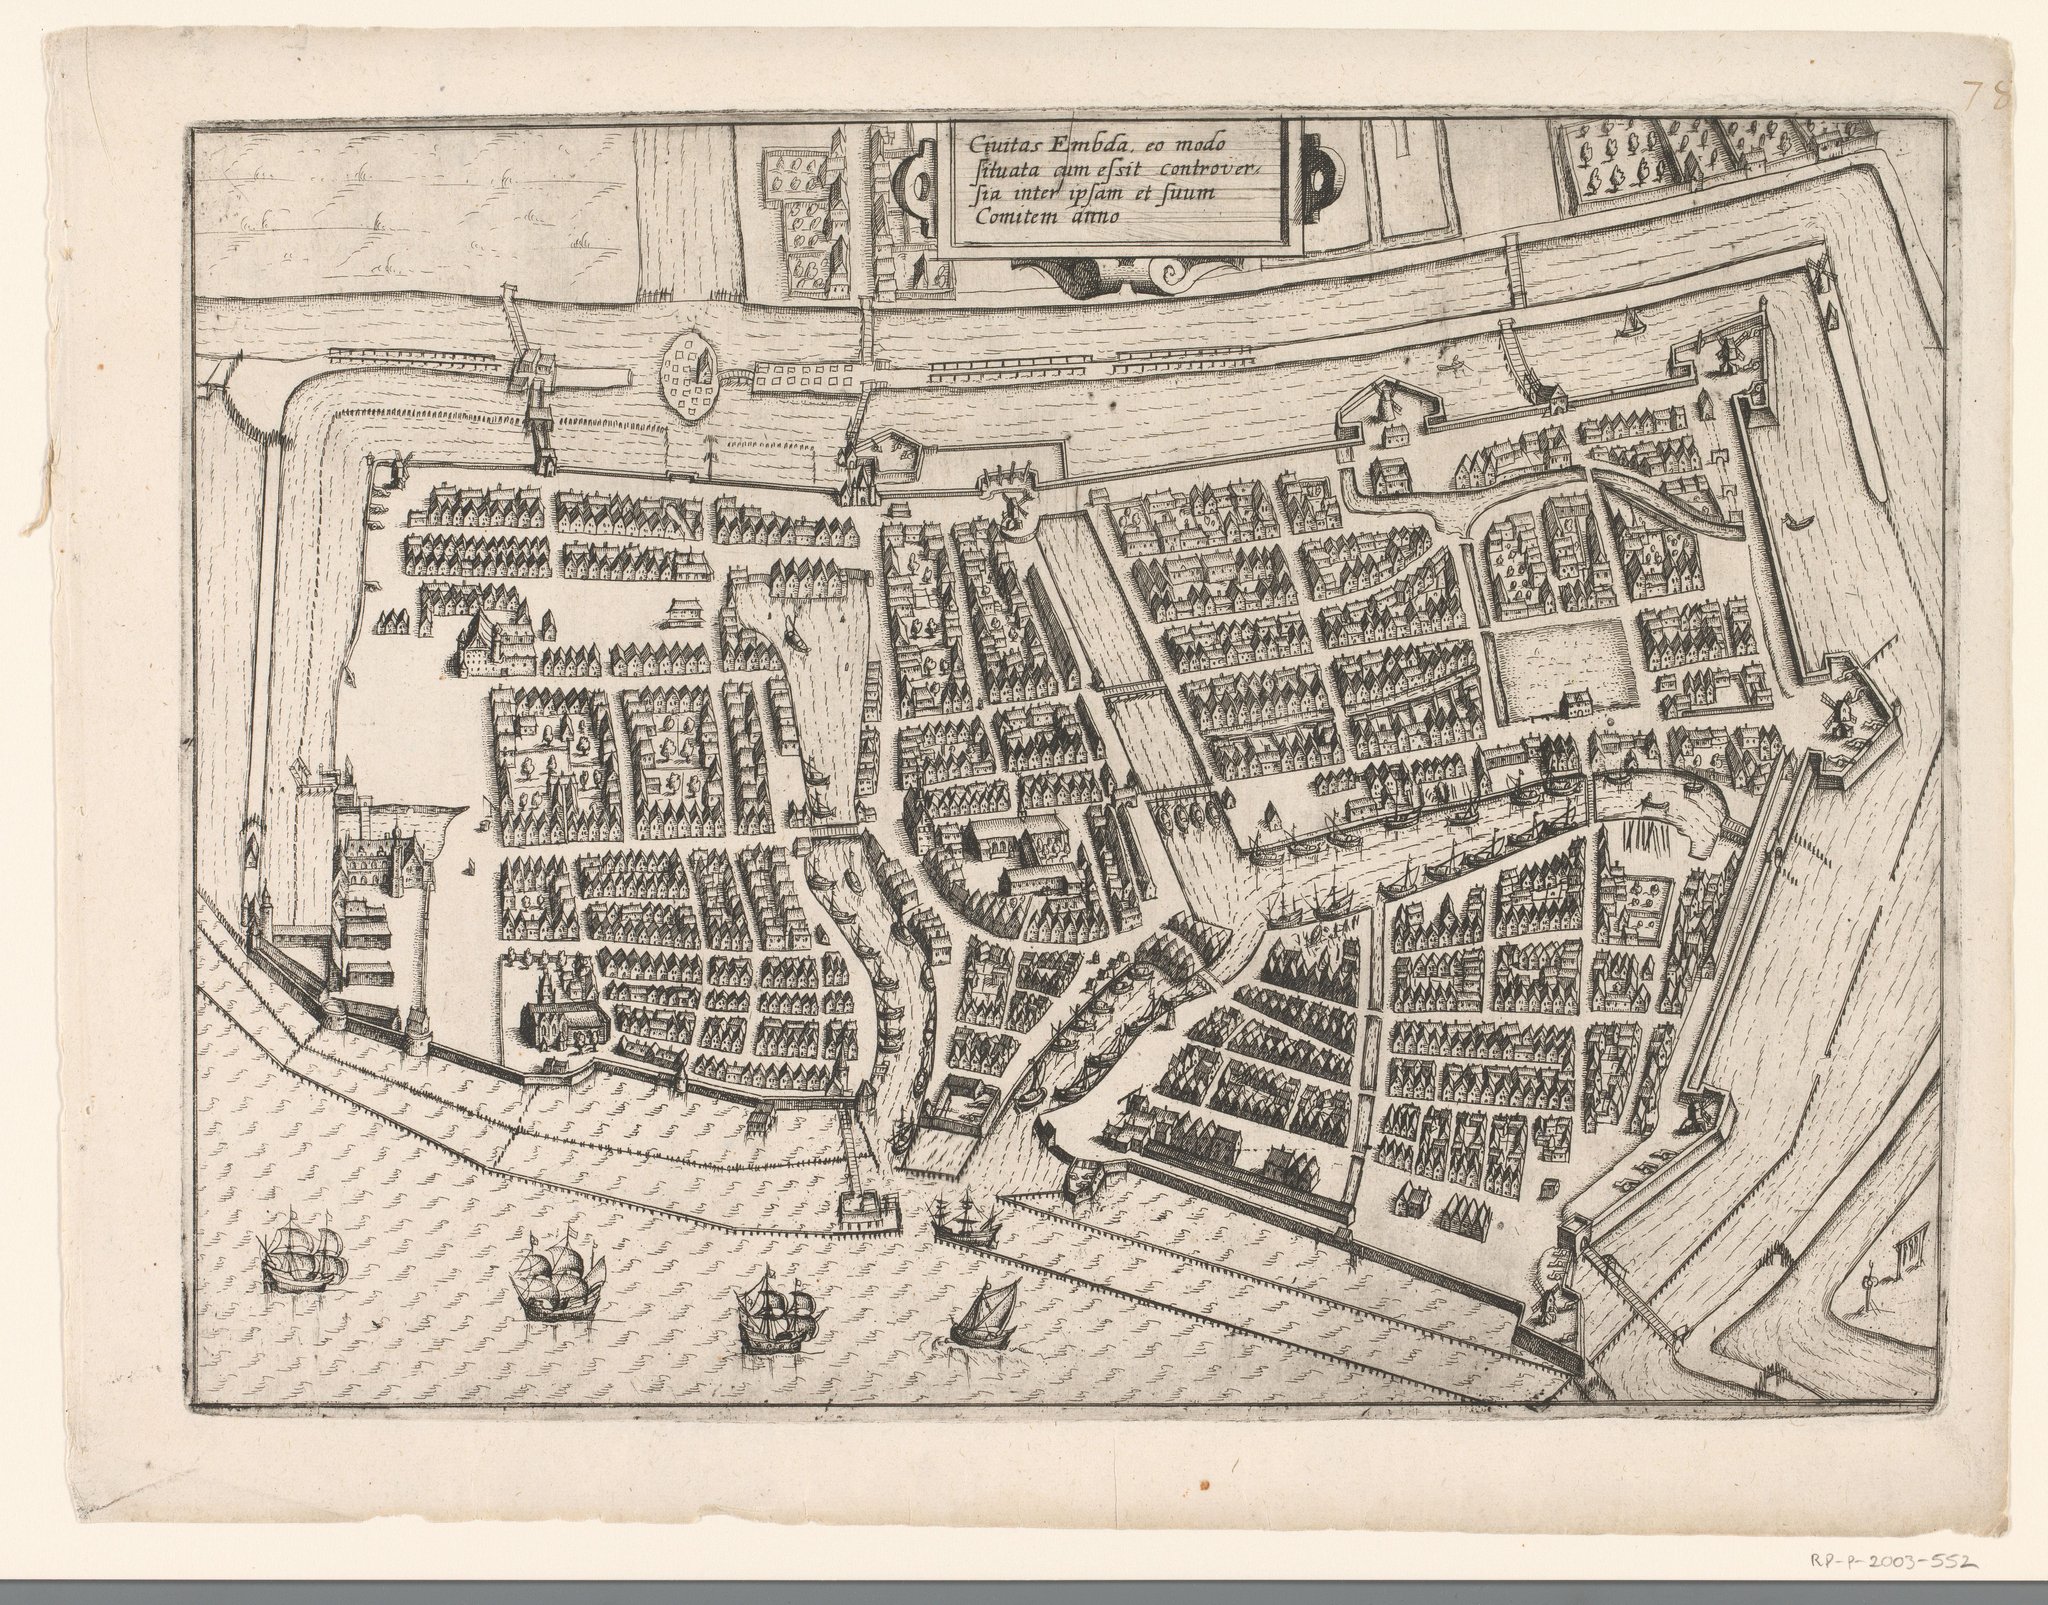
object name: area plan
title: Civitas Embda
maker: Anonymous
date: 1607-1609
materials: paper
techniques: etching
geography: northern netherlands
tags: maps of cities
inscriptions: number: ‘78’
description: Plattegrond van de stad Emden. Midden boven een cartouche met de Latijnse titel. Onderdeel van de verzameling kaarten genomen uit een latere editie van: Descrittione di tutti i Paesi Bassi van Lodovico Guicciardini.